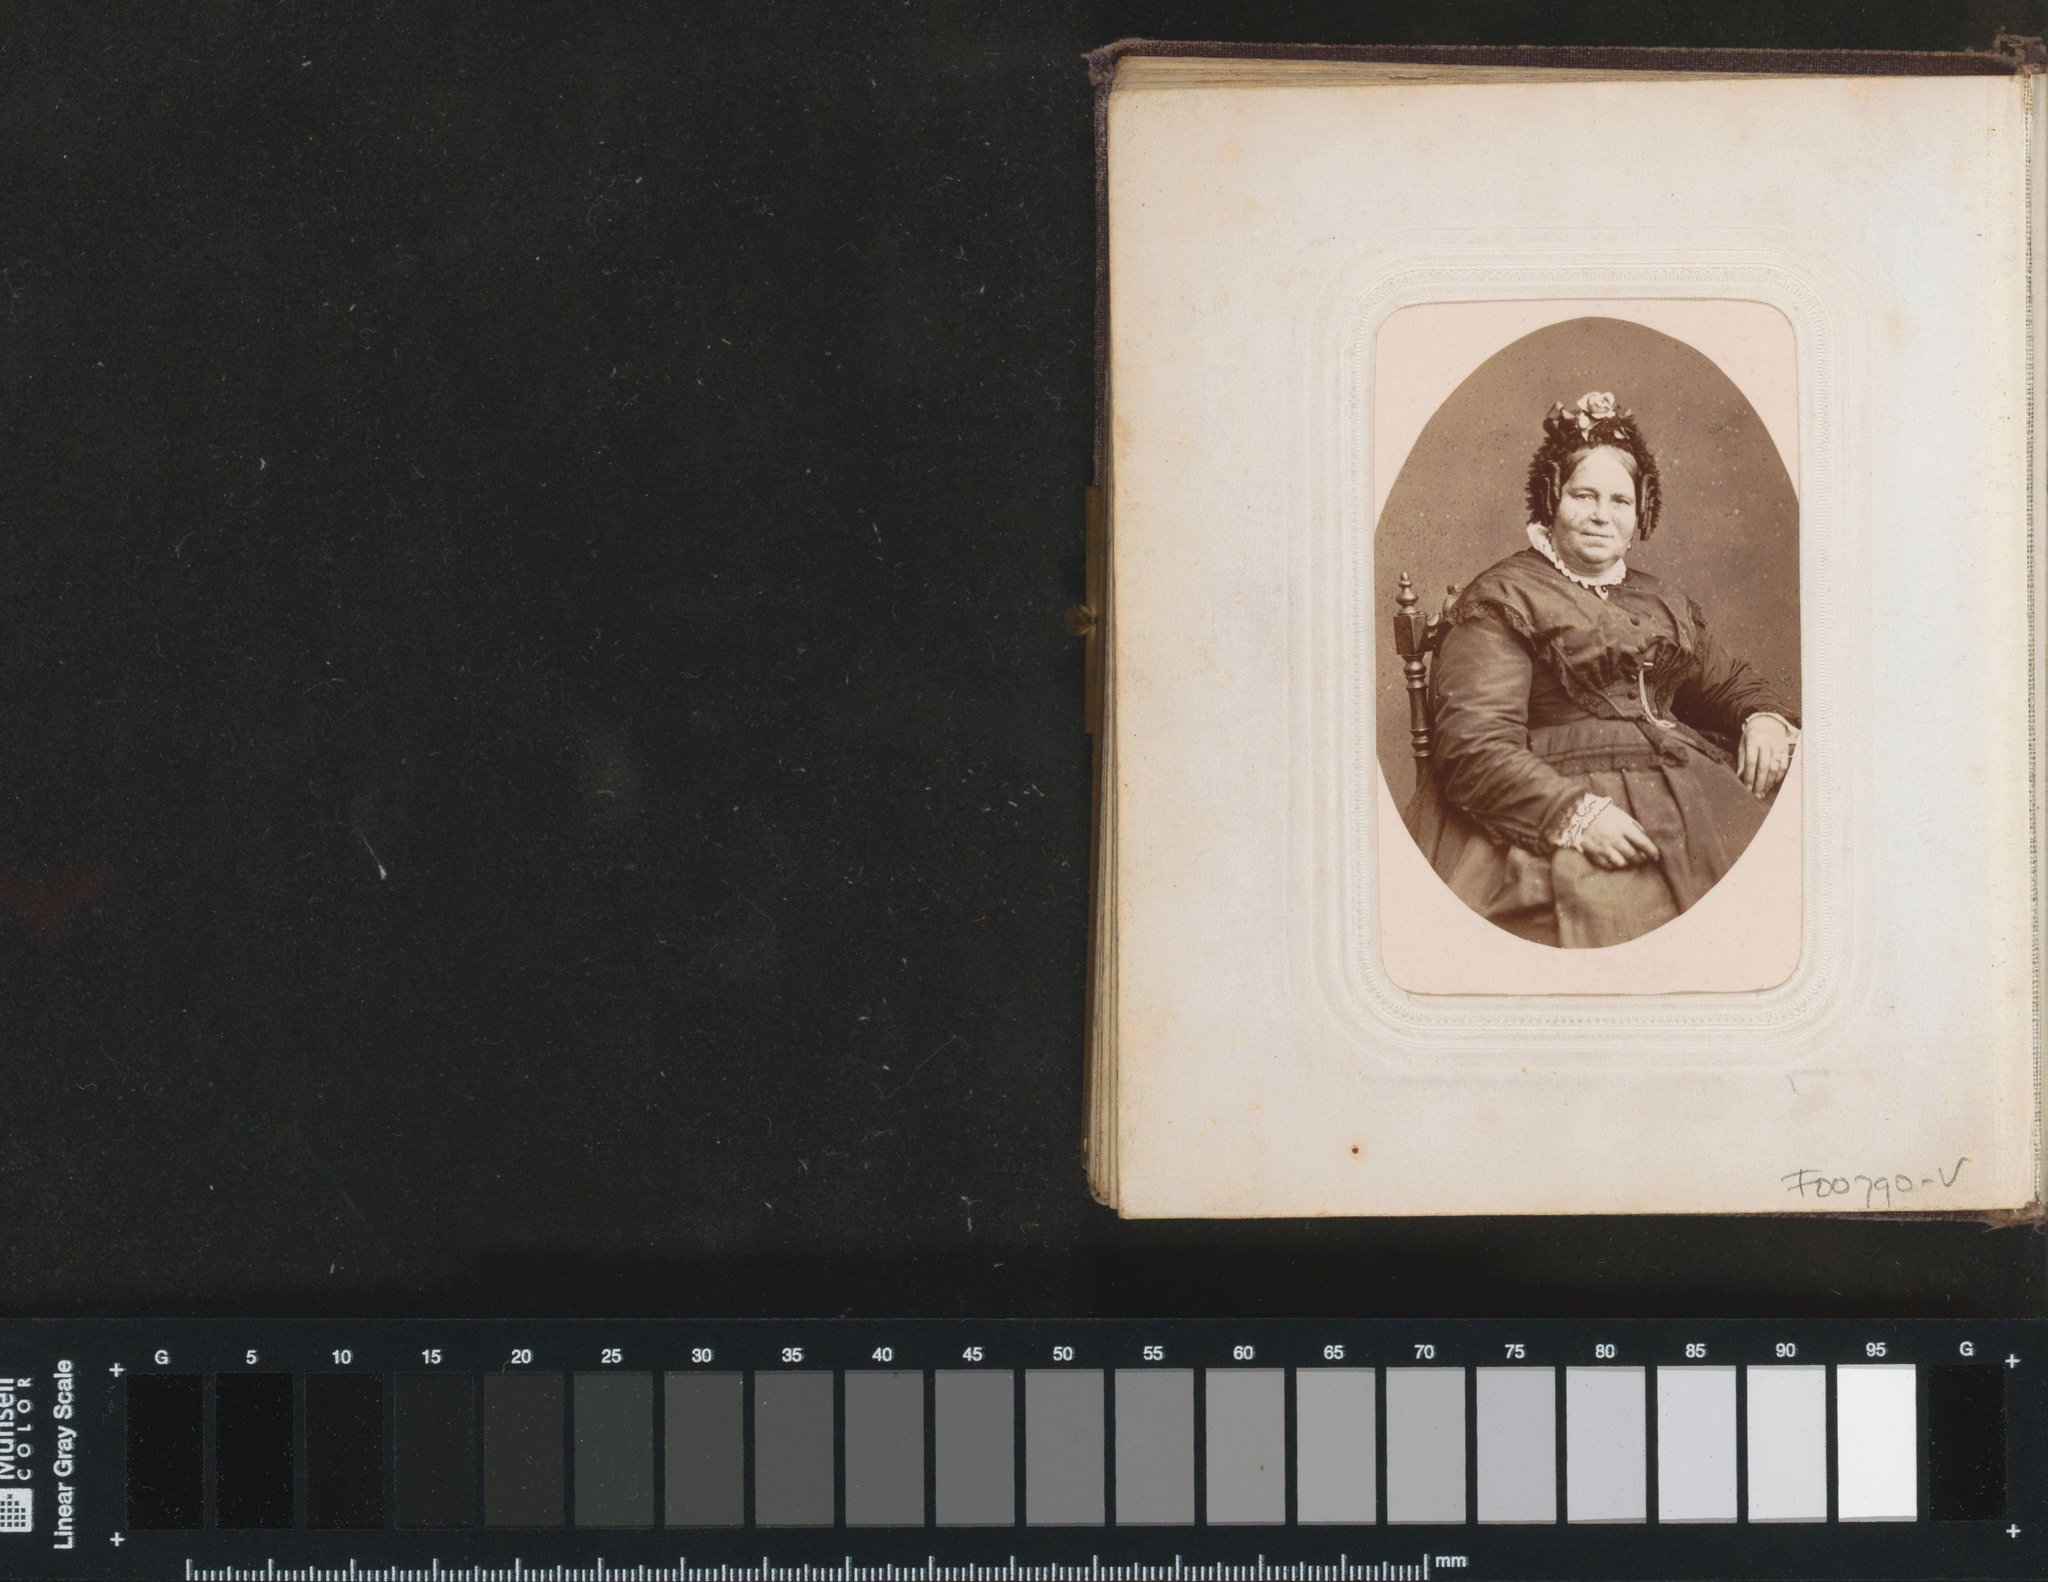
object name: carte de visite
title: Portret van een zittende vrouw met pijpenkrullen en een muts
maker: théodor weijnen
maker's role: fotograaf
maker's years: 1835-1904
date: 1860-1870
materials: cardboard, paper, photographic support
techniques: albumen print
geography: maastricht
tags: studio requisites ~ photographer, styles of hairdress - aa - ~ women, head-gear: cap, dress, gown, maastricht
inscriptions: address: ‘Rue du Casque 1776 Maestricht’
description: Onderdeel van Fotoalbum met 26 cartes-de-visite van rooms-katholieke geestelijken.